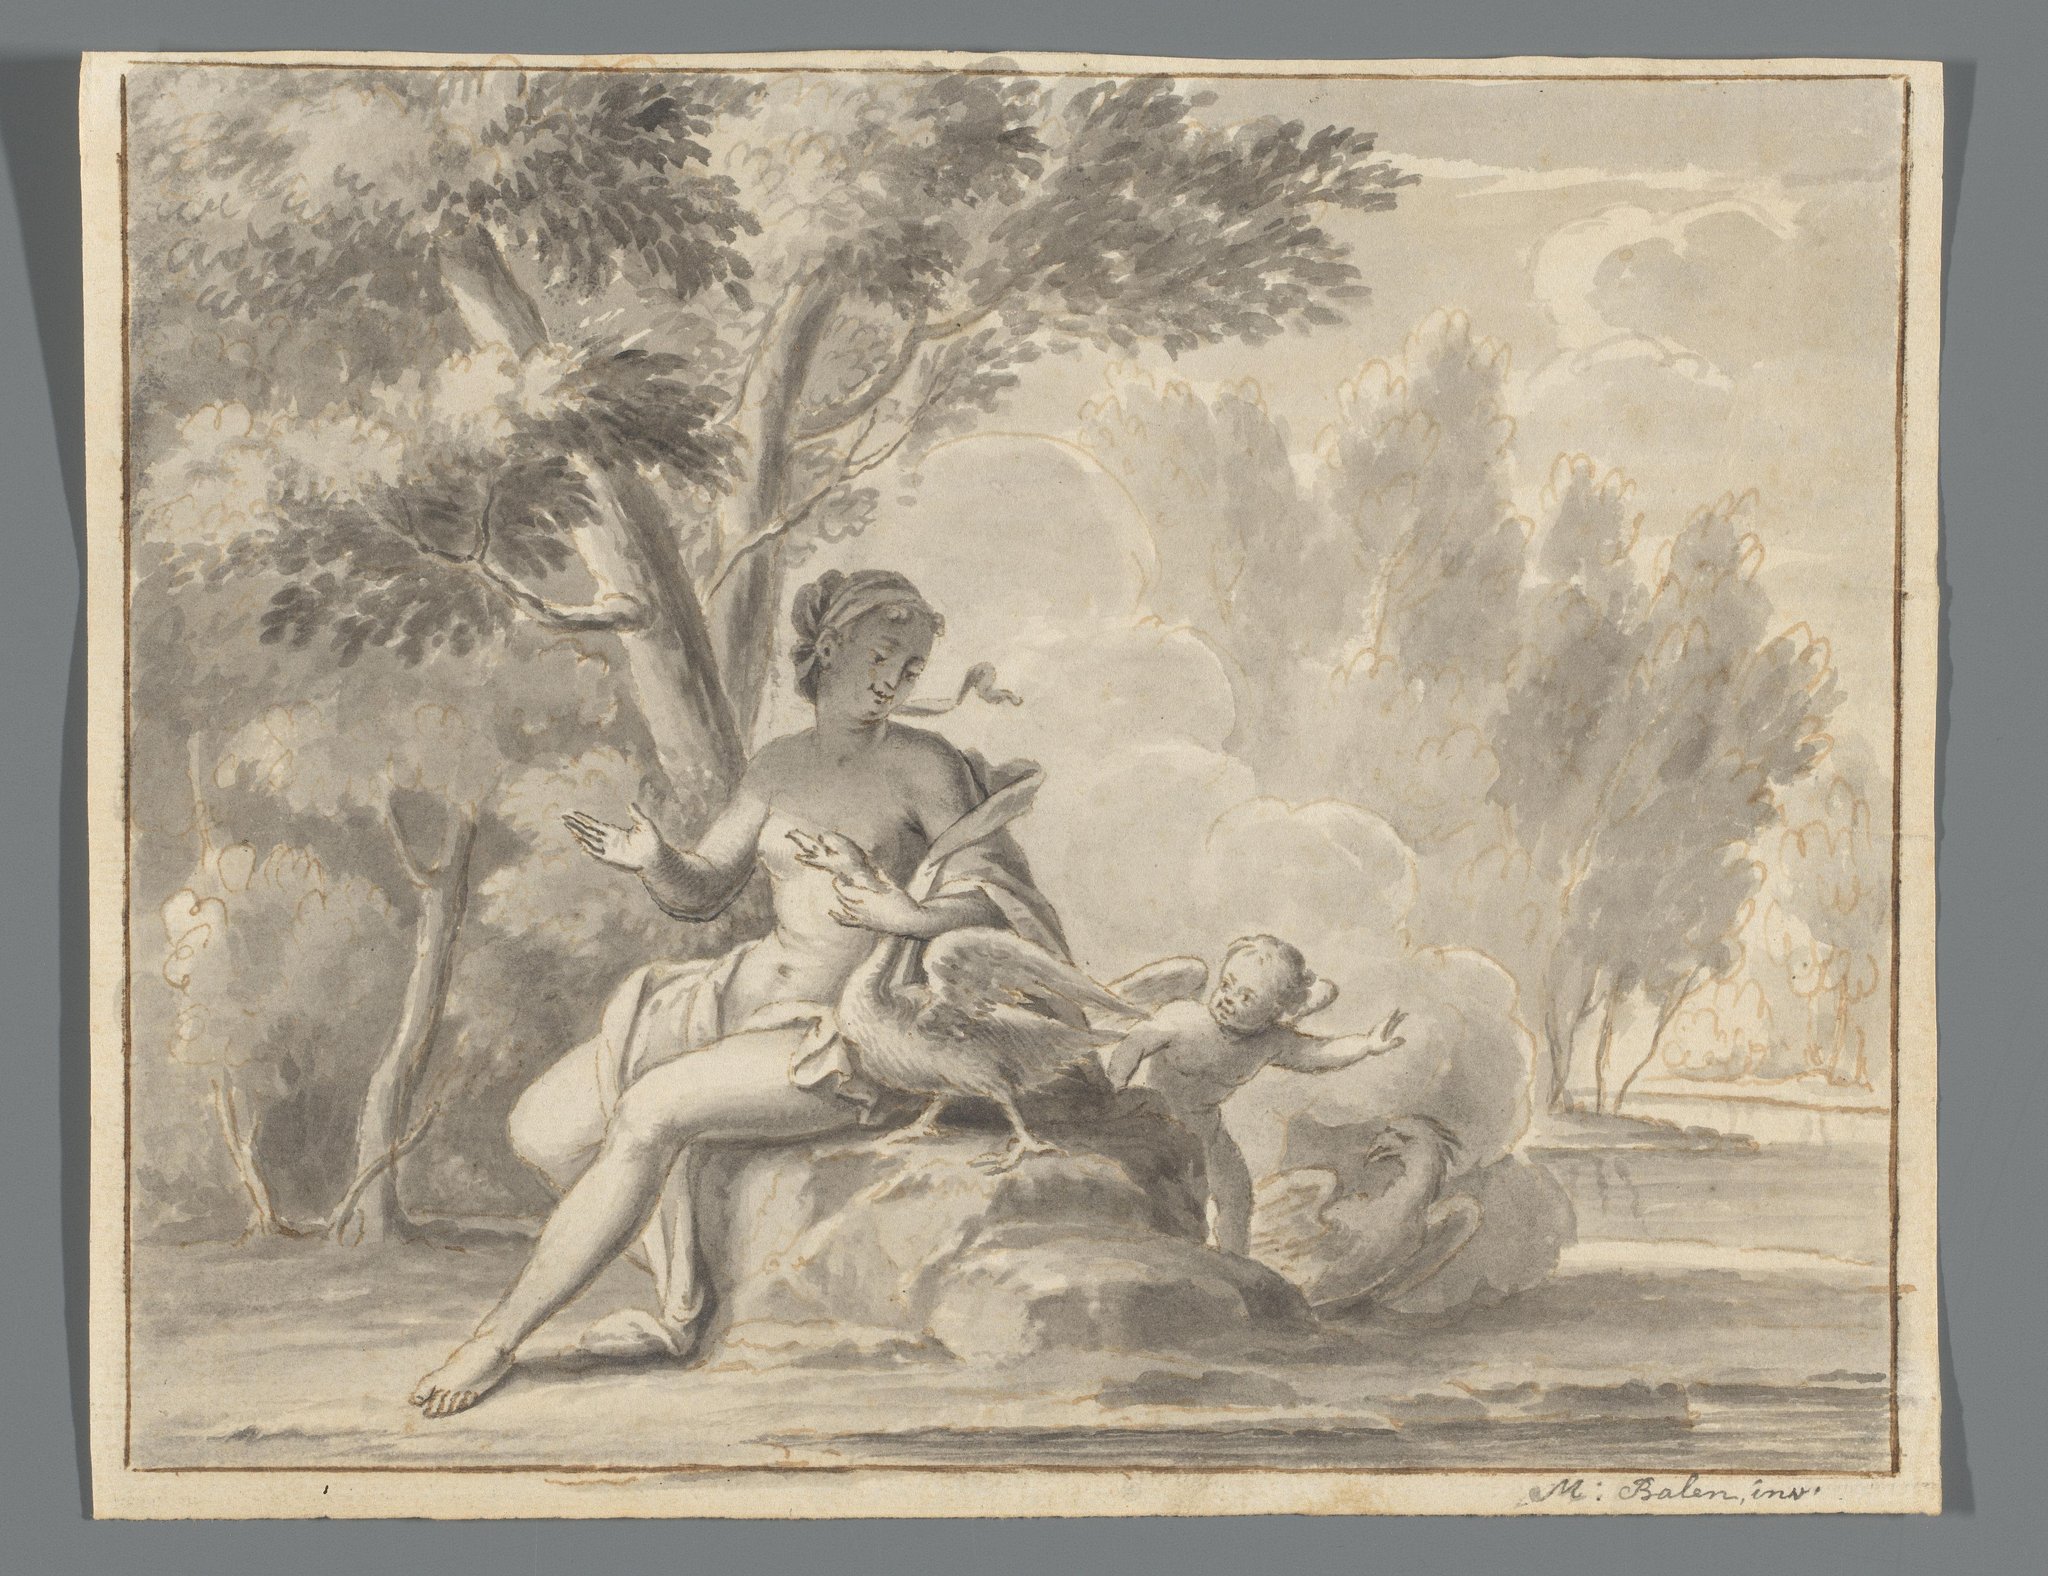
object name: drawing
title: Leda en de zwaan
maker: matthijs balen (1684-1766)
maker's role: draughtsman, painter, print maker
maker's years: 1684-1766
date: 1694-1766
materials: paper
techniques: brush, pen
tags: jupiter, in the shape of a swan, and leda